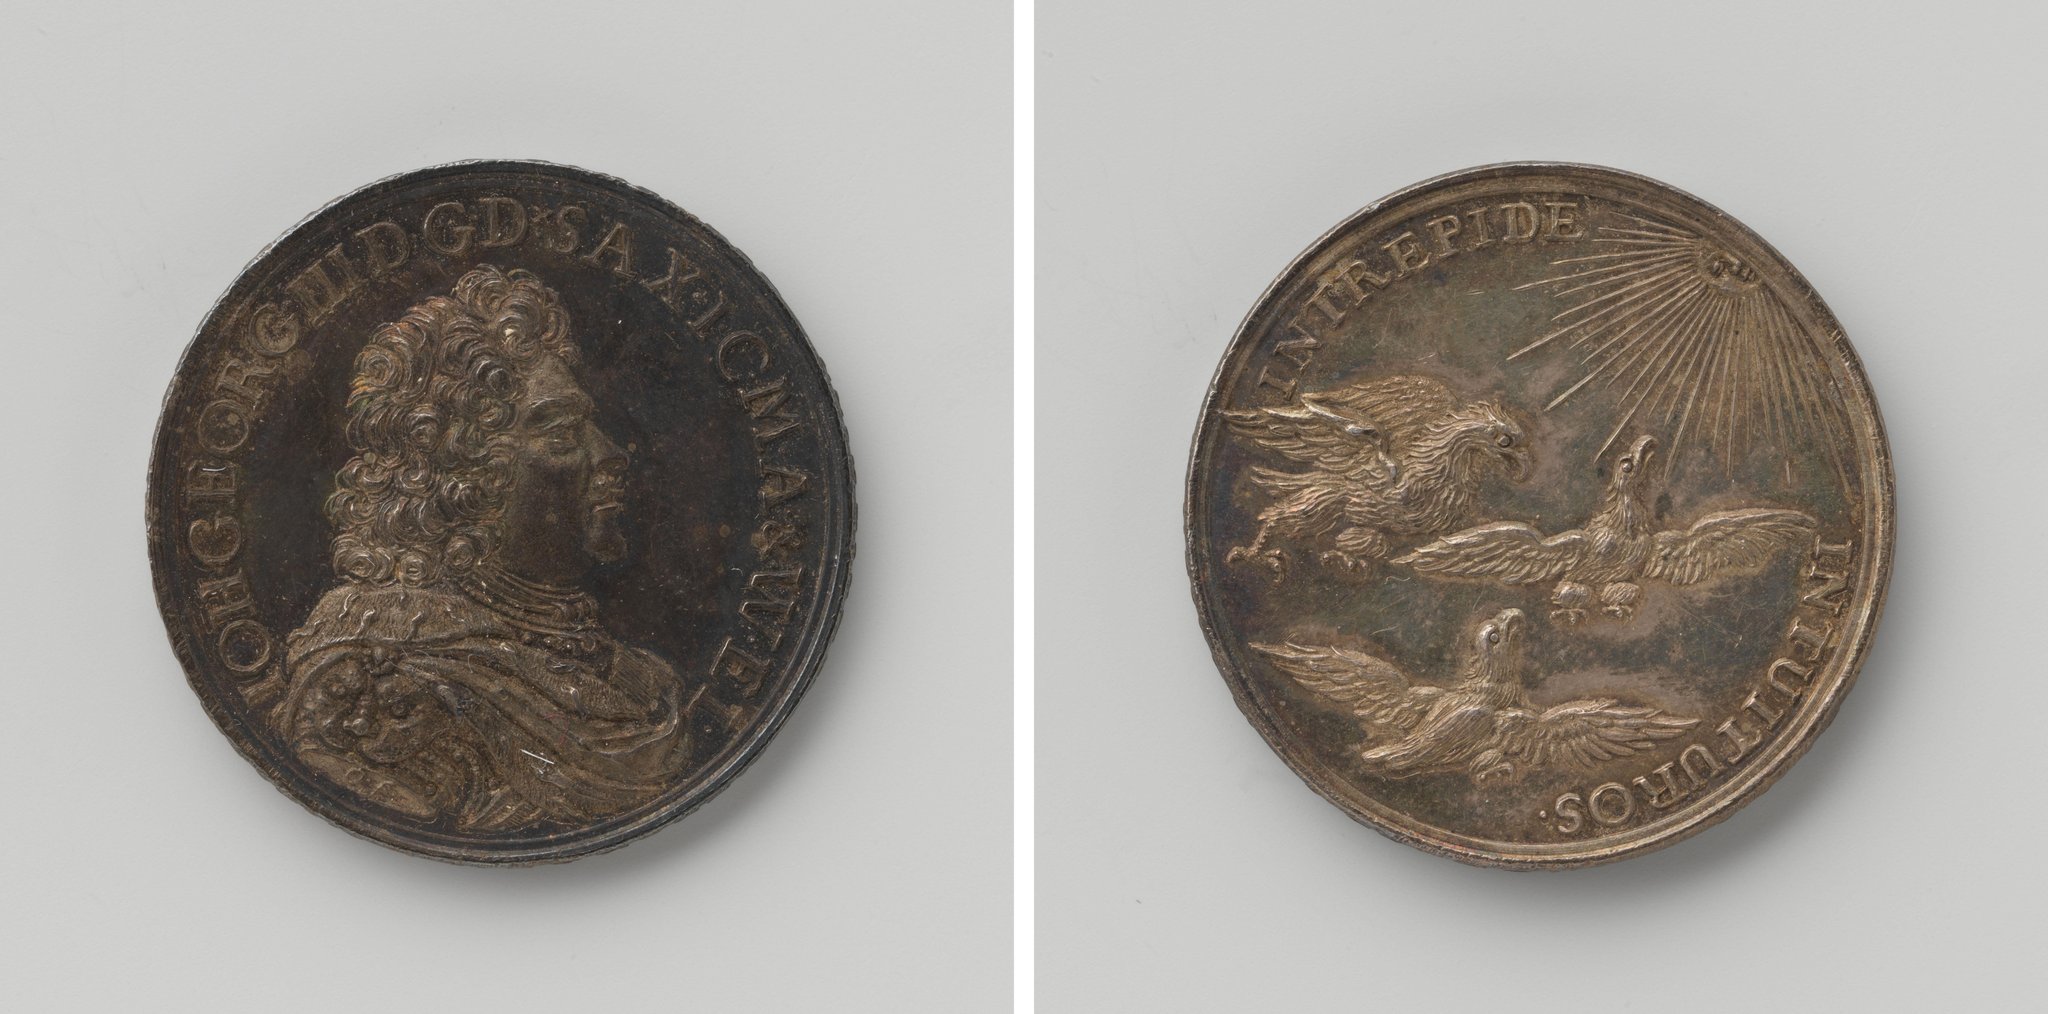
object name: history medal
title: Belegering van Mainz door Johan Georg III, keurvorst van Saksen en zijn beide zonen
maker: martin heinrich omeis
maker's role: print maker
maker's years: 1650-1703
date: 1689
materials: silver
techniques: striking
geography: dresden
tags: august ii (king of poland)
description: Zilveren penning. Voorzijde: borststuk man binnen omschrift. Keerzijde: twee jonge arenden vliegen onder leiding van oudere arend naar zon binnen omschrift; randschrift